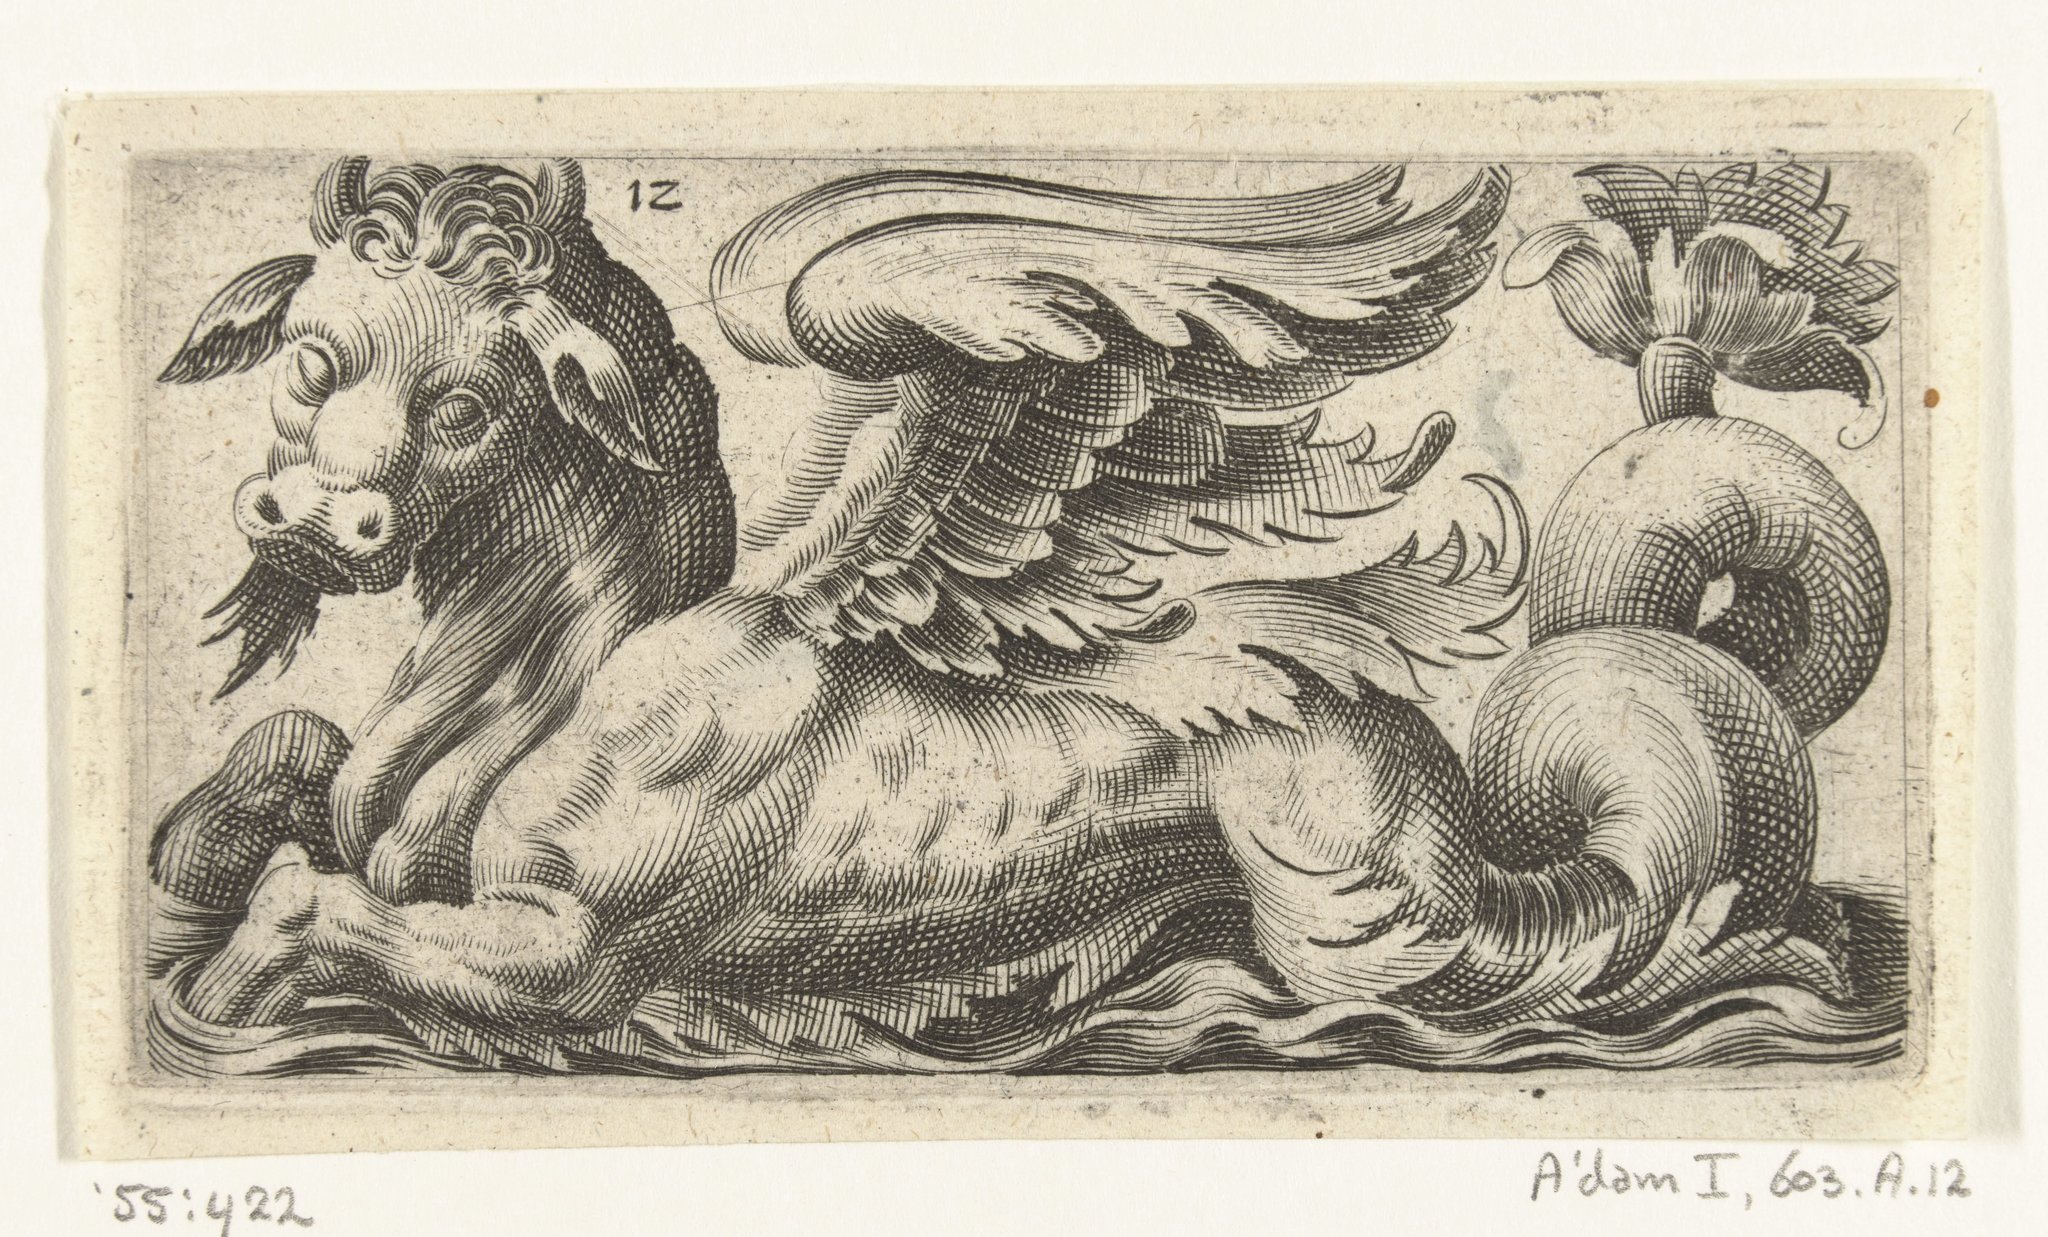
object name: ornament print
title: Friezen met zeemonsters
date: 1526-1606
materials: paper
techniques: engraving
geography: germany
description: Tegenzijdige kopie naar prent met objectnummer RP-P-1984-439.